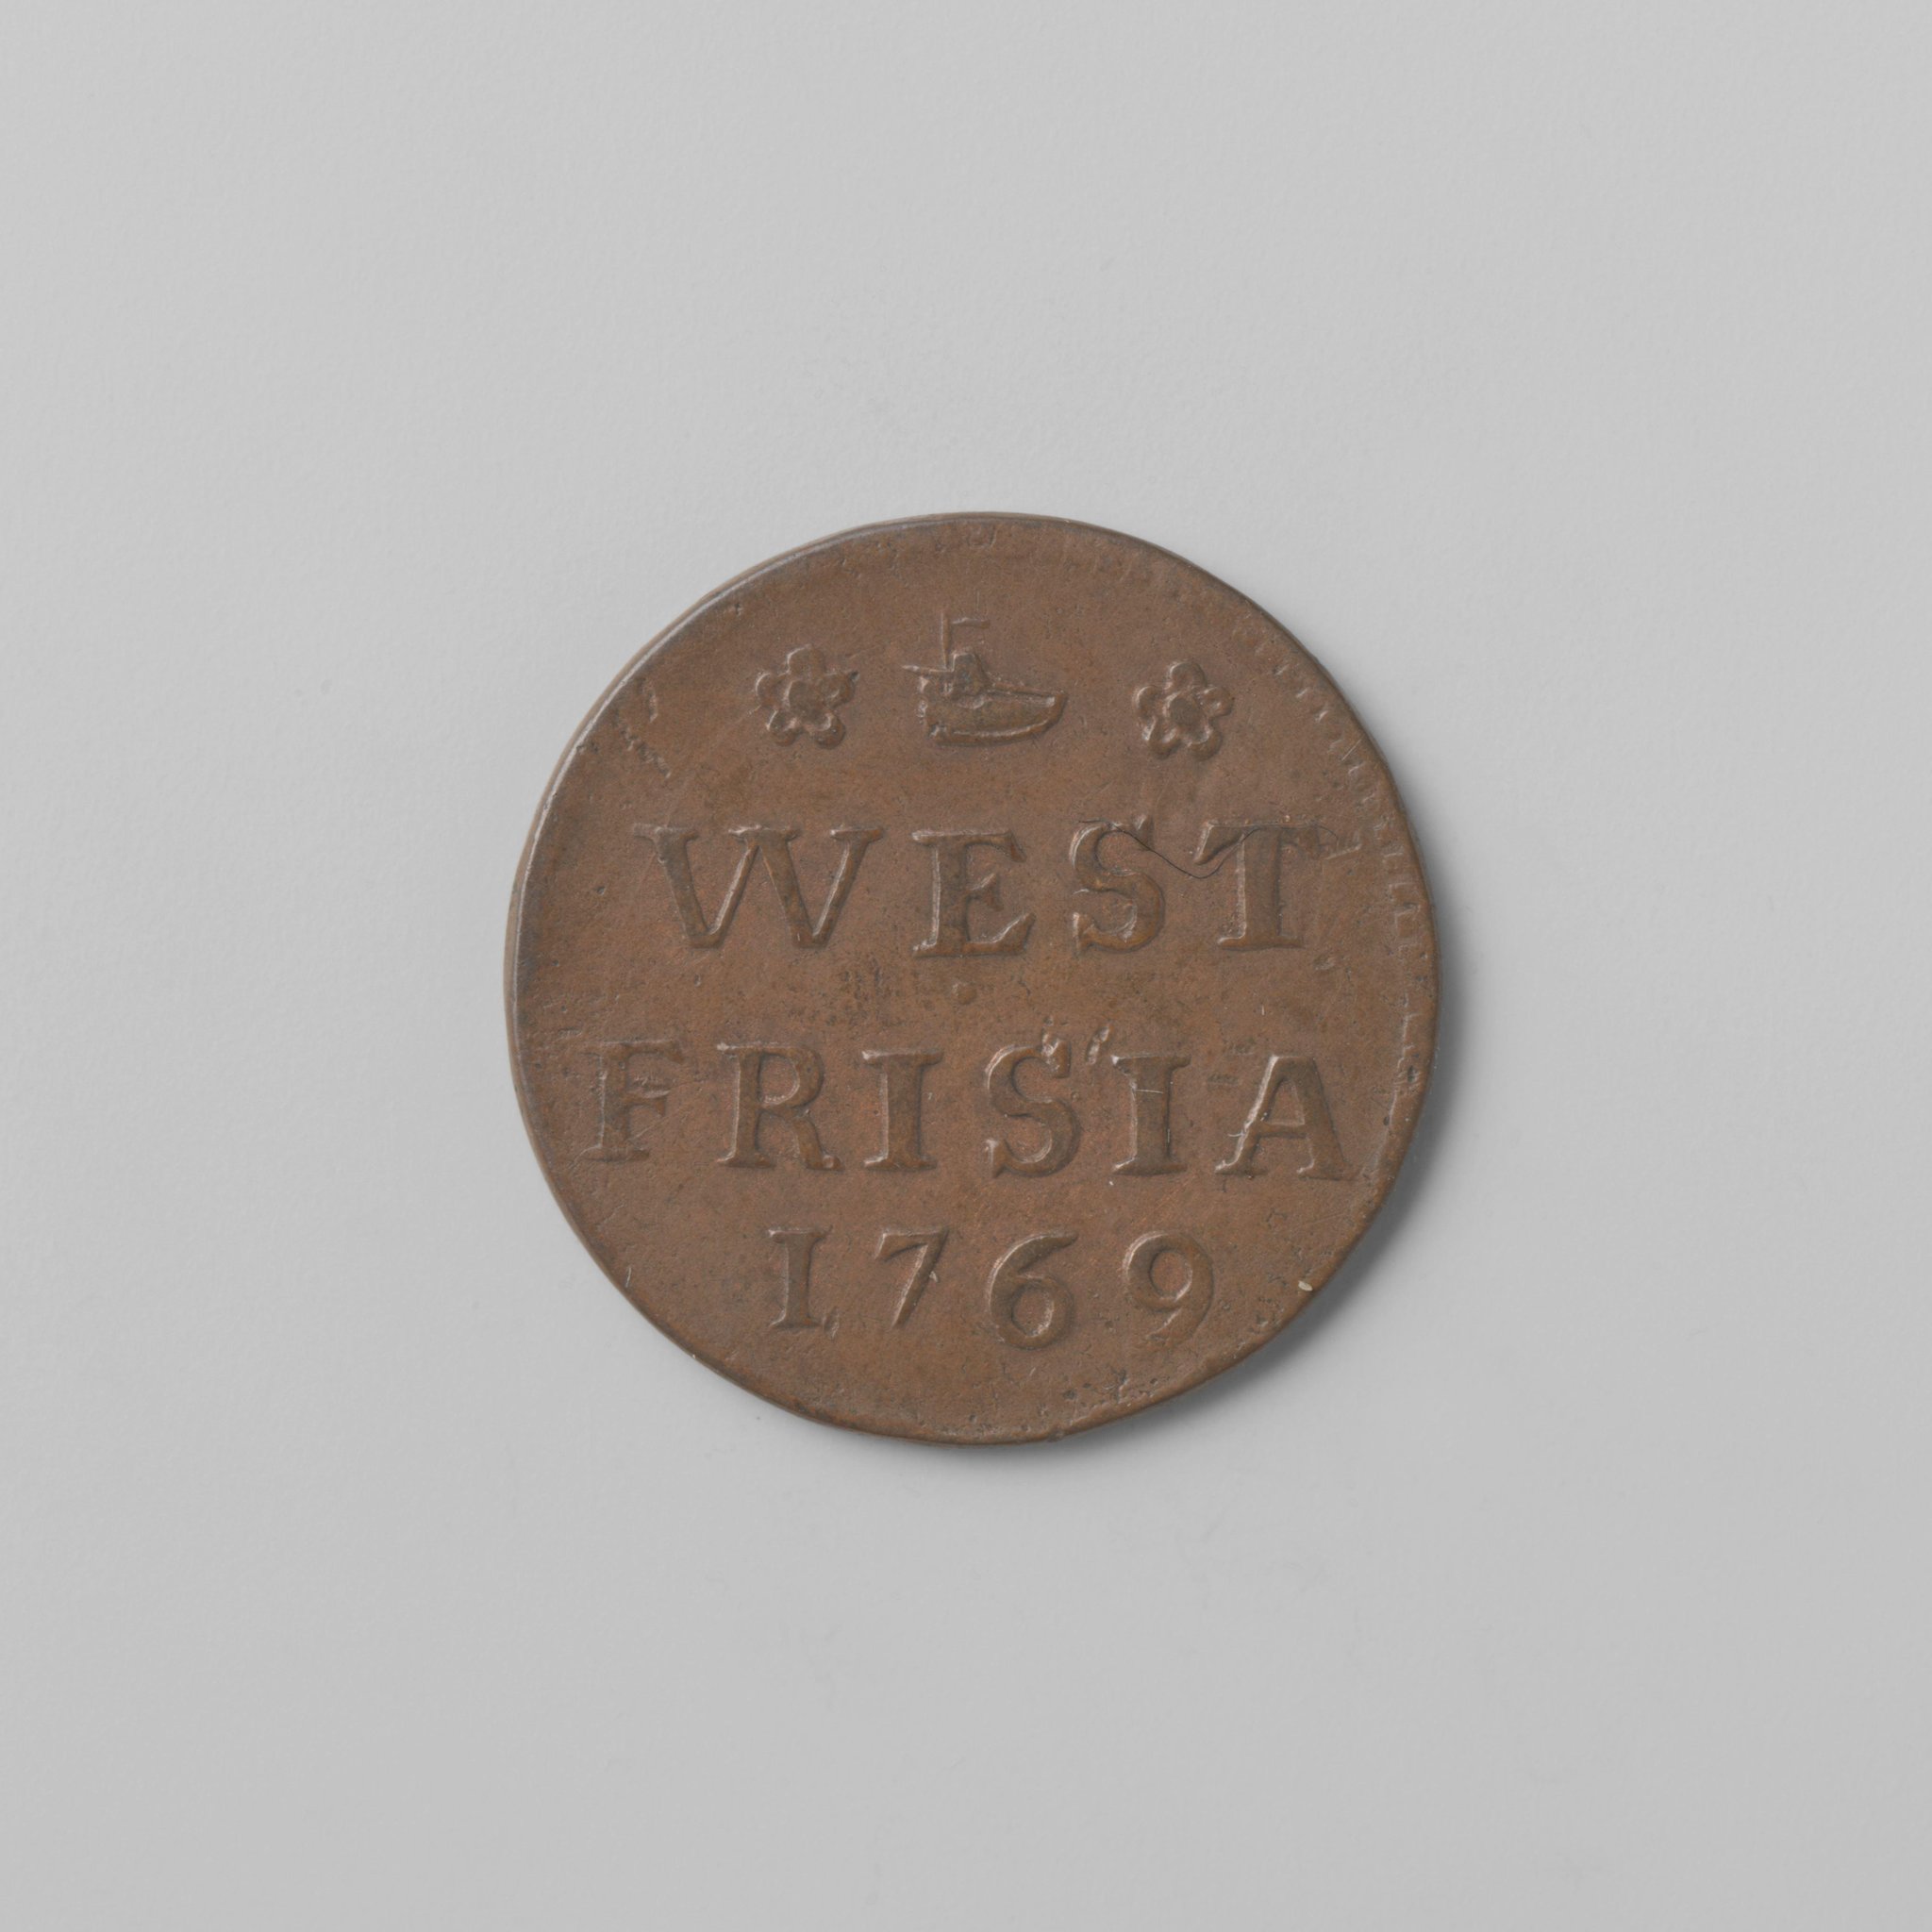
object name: coin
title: West-Friesland, duit, 1769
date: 1769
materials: copper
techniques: striking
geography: west frisia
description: Koperen munt. Voorzijde: gekroond wapenschild van West-Friesland met lauwertakken. Keerzijde: opschrift in twee regels. Daarboven muntmeesterteken haringbuis tussen twee rozetten. Daaronder jaartal.